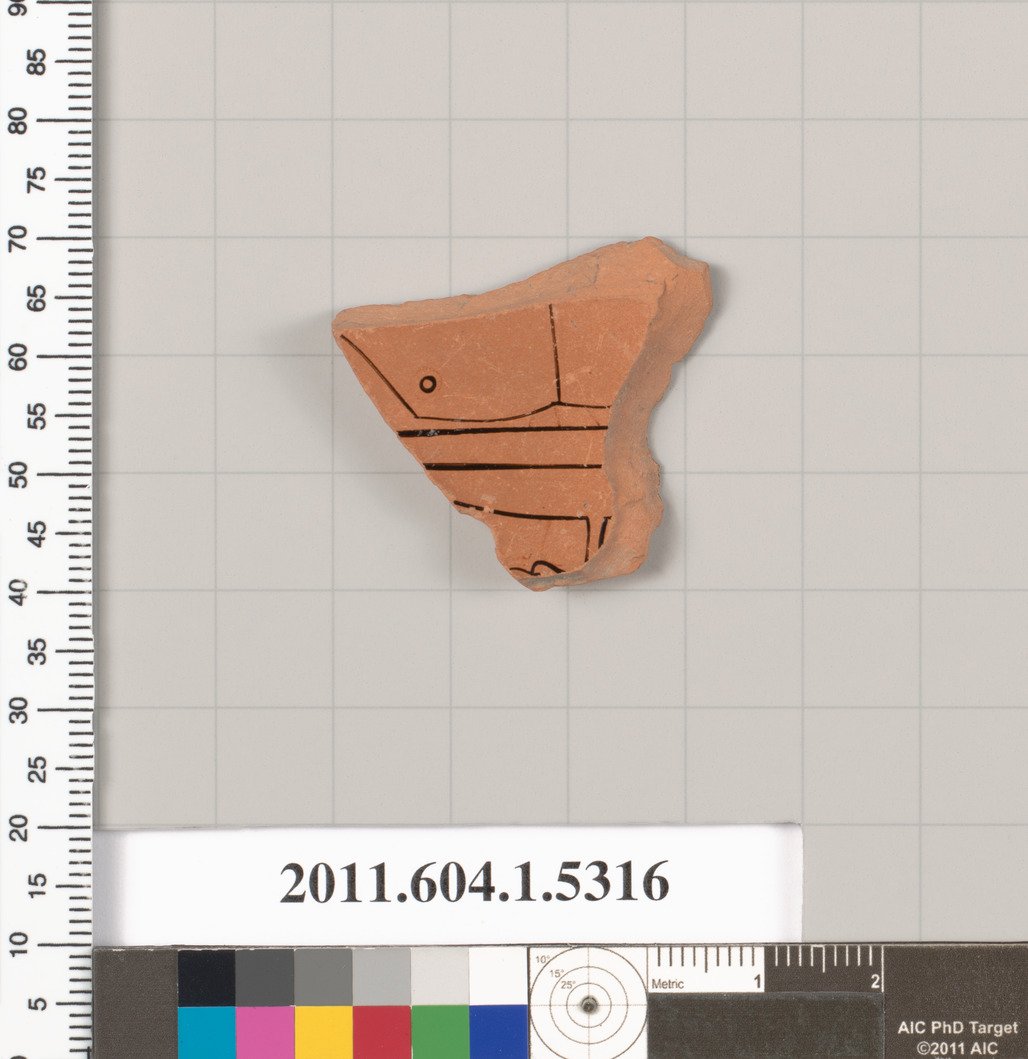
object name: kylix fragment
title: Terracotta fragment of a kylix (drinking cup)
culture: greek, attic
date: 500-480 BCE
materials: terracotta